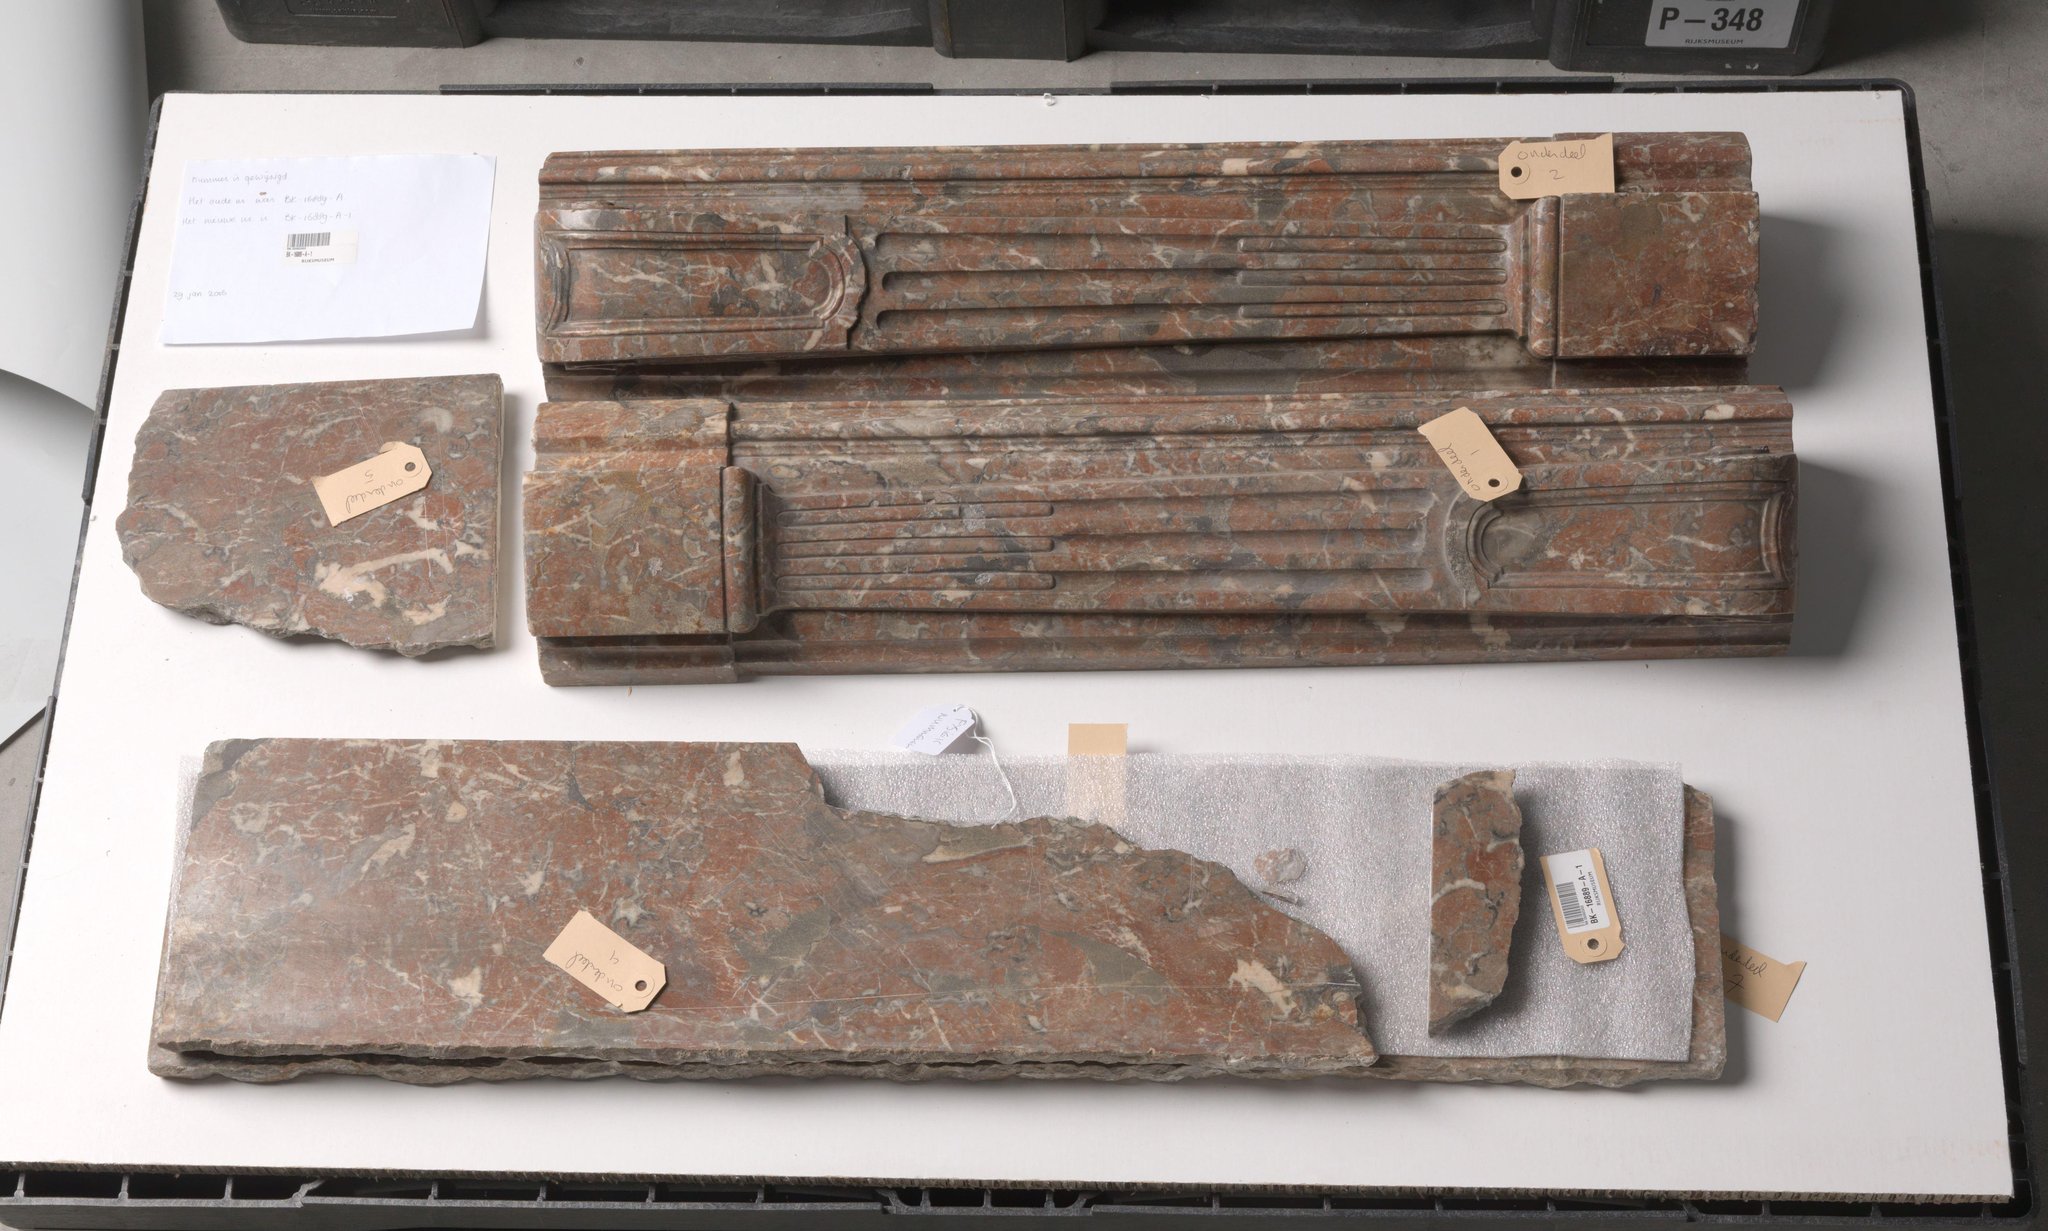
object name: mantel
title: Onderdelen van een schoorsteenmantel van marmer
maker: Anonymous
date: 1700-1750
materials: marble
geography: france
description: Onderdelen van een schoorsteenmantel van marmer met de nummers BK-16889-3 tm -8. Horend bij een betimmering van eikenhout.